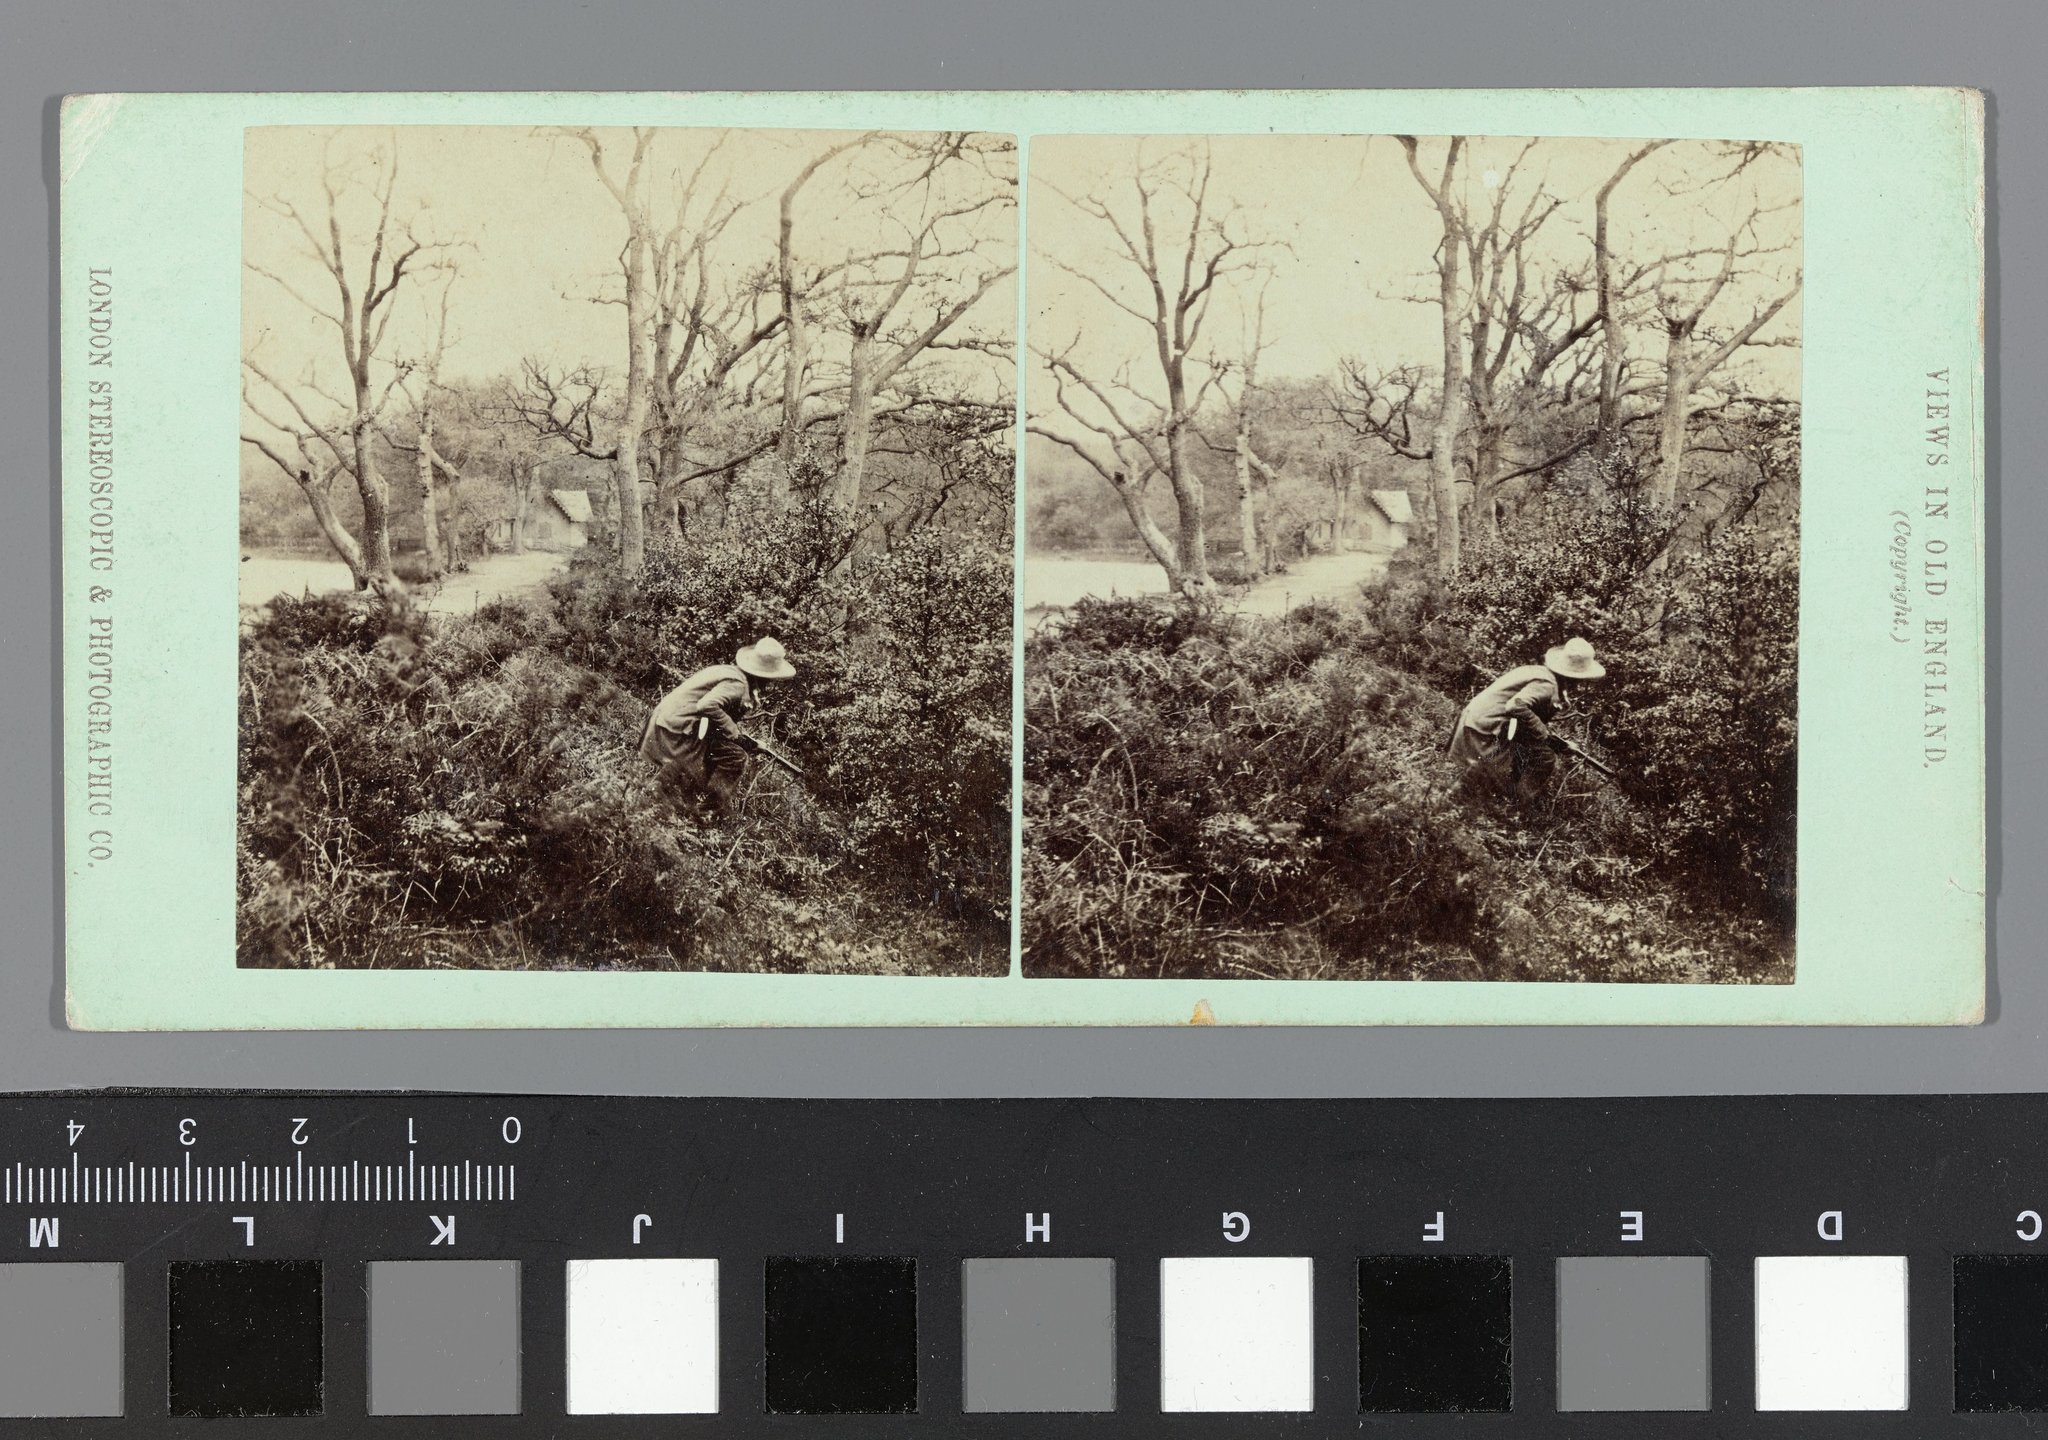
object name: stereograph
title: Jager in het struikgewas in Engeland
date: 1860-1880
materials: cardboard, paper, photographic support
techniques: albumen print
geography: england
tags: forest of coniferous trees, hunter, england